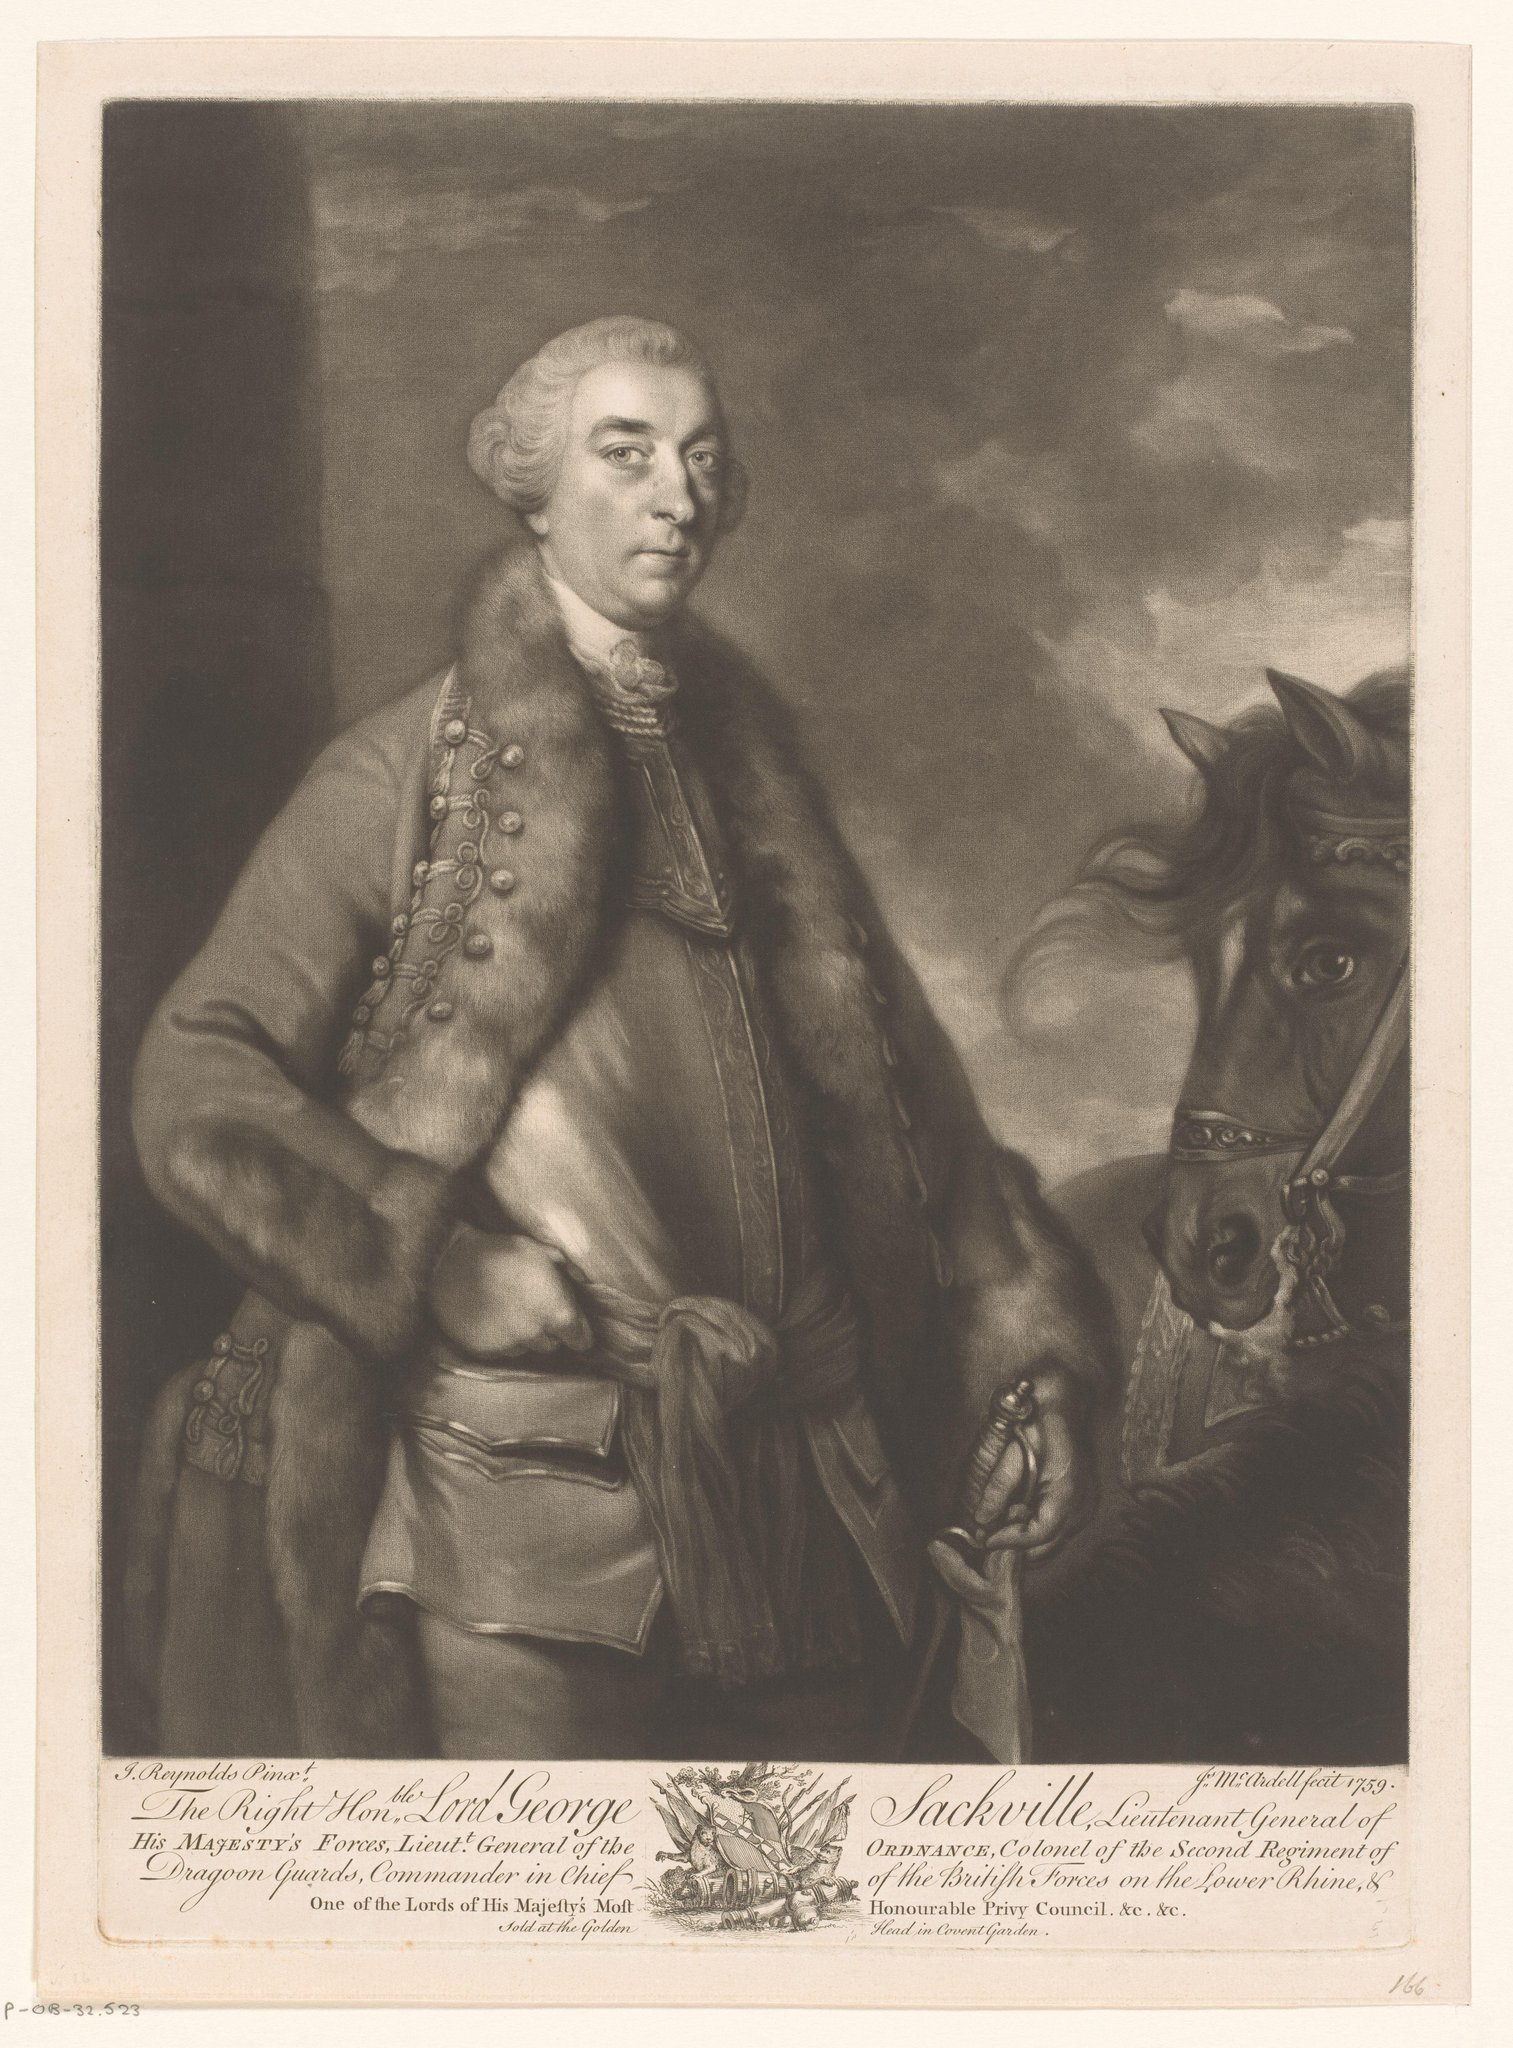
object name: print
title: Portret van George Germain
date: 1759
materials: paper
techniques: mezzotint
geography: london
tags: historical persons, politician, e.g. party leader, horse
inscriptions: collector's mark: Lugt 240